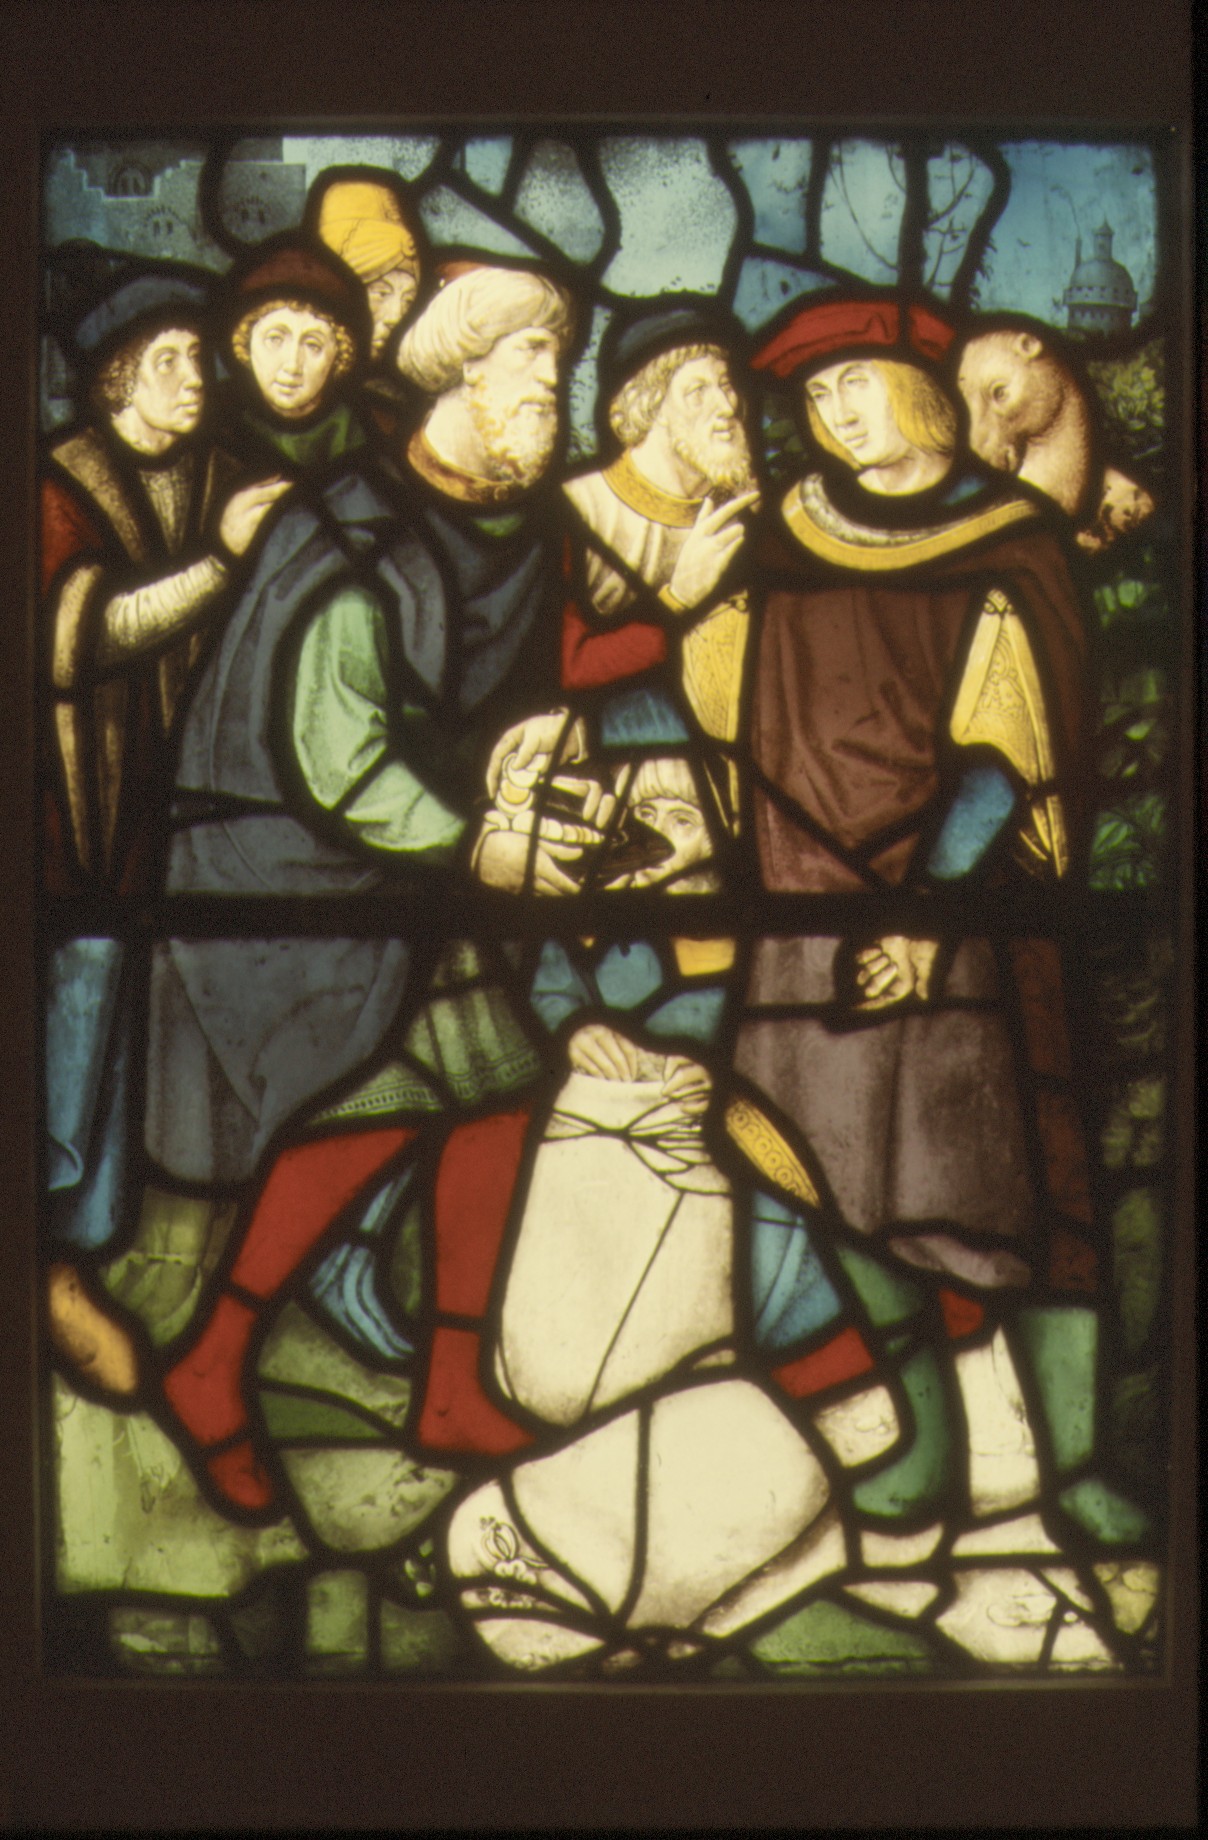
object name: panel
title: Joseph's Brethren Discover Money in Their Grain Sacks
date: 1530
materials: glass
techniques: enamel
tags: men